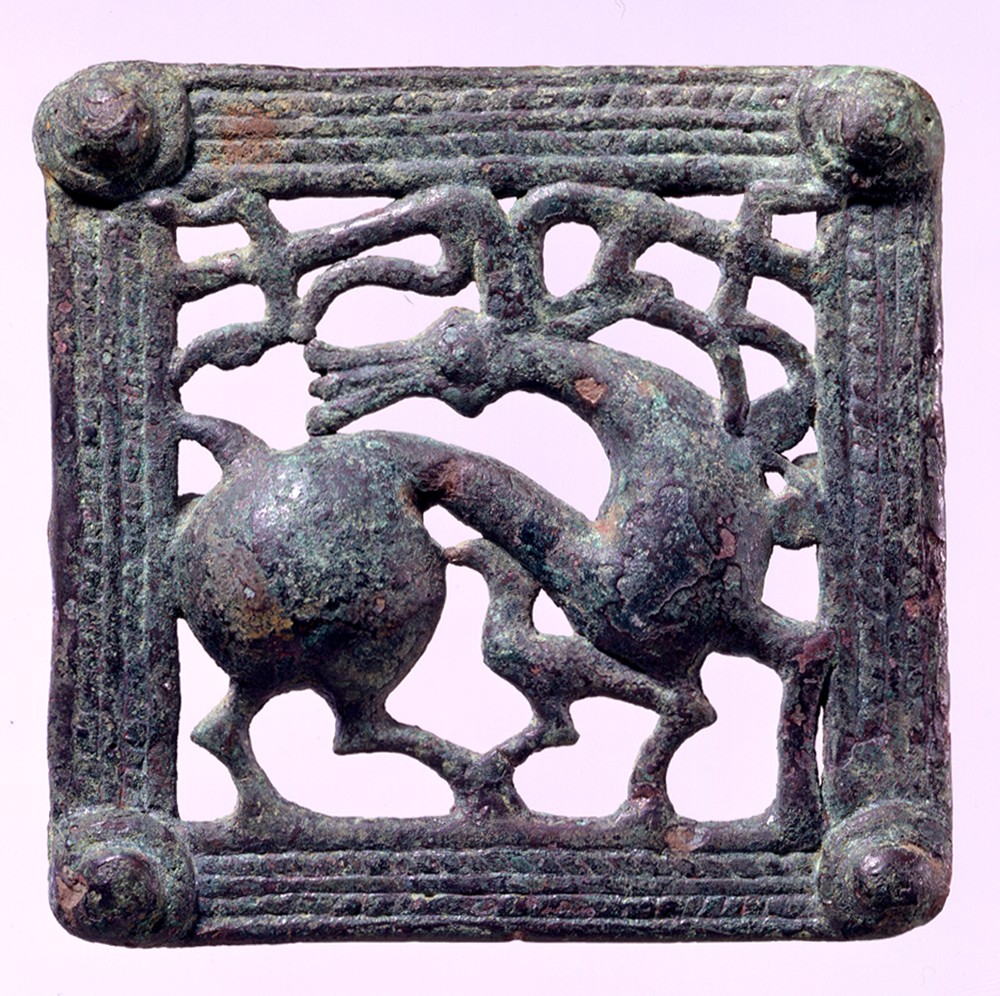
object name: belt buckle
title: Belt Buckle with Stag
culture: ossetian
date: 1-200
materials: brass, bronze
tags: animals